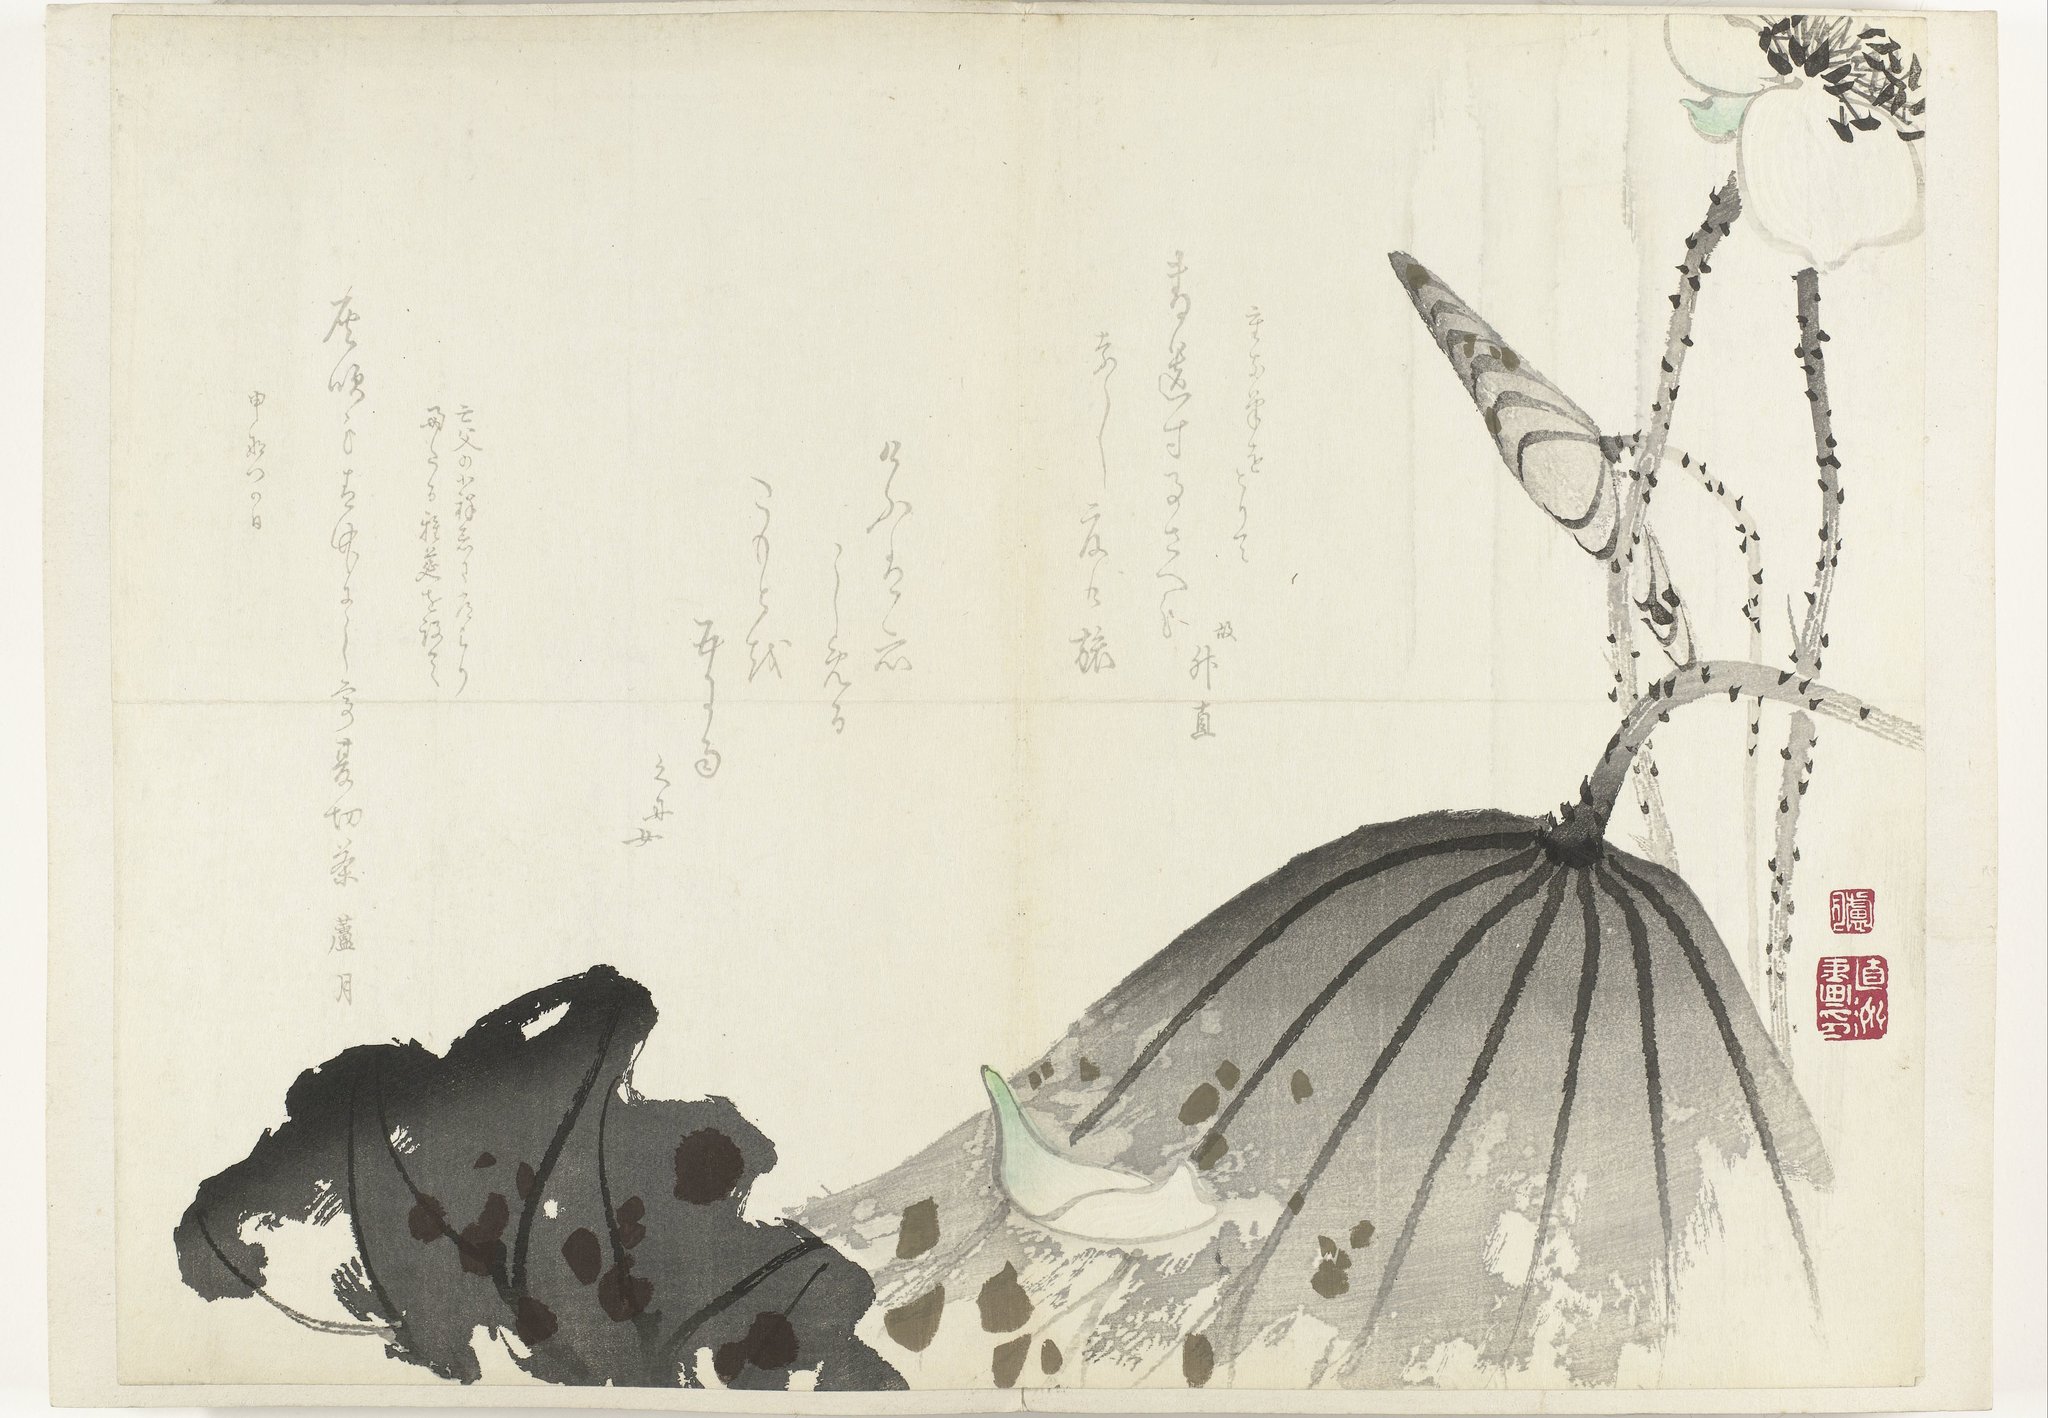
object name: album leaf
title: Album Shijo-surimono uit de periode 1840-1900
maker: Anonymous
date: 1840-1900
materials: paper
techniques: woodcut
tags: flowers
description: Een surimono is een luxe uitgevoerde prent waarop beeld met één of meerdere gedichten gecombineerd is. Bij het drukken van een surimono werd vaak gebruik gemaakt van dikker papier, blinddruk en metaal pigmenten, zoals koper- en zilverpoeder. De prenten werden vaak in opdracht van dichters gemaakt en als exclusief geschenk aan vrienden en relaties gegeven.